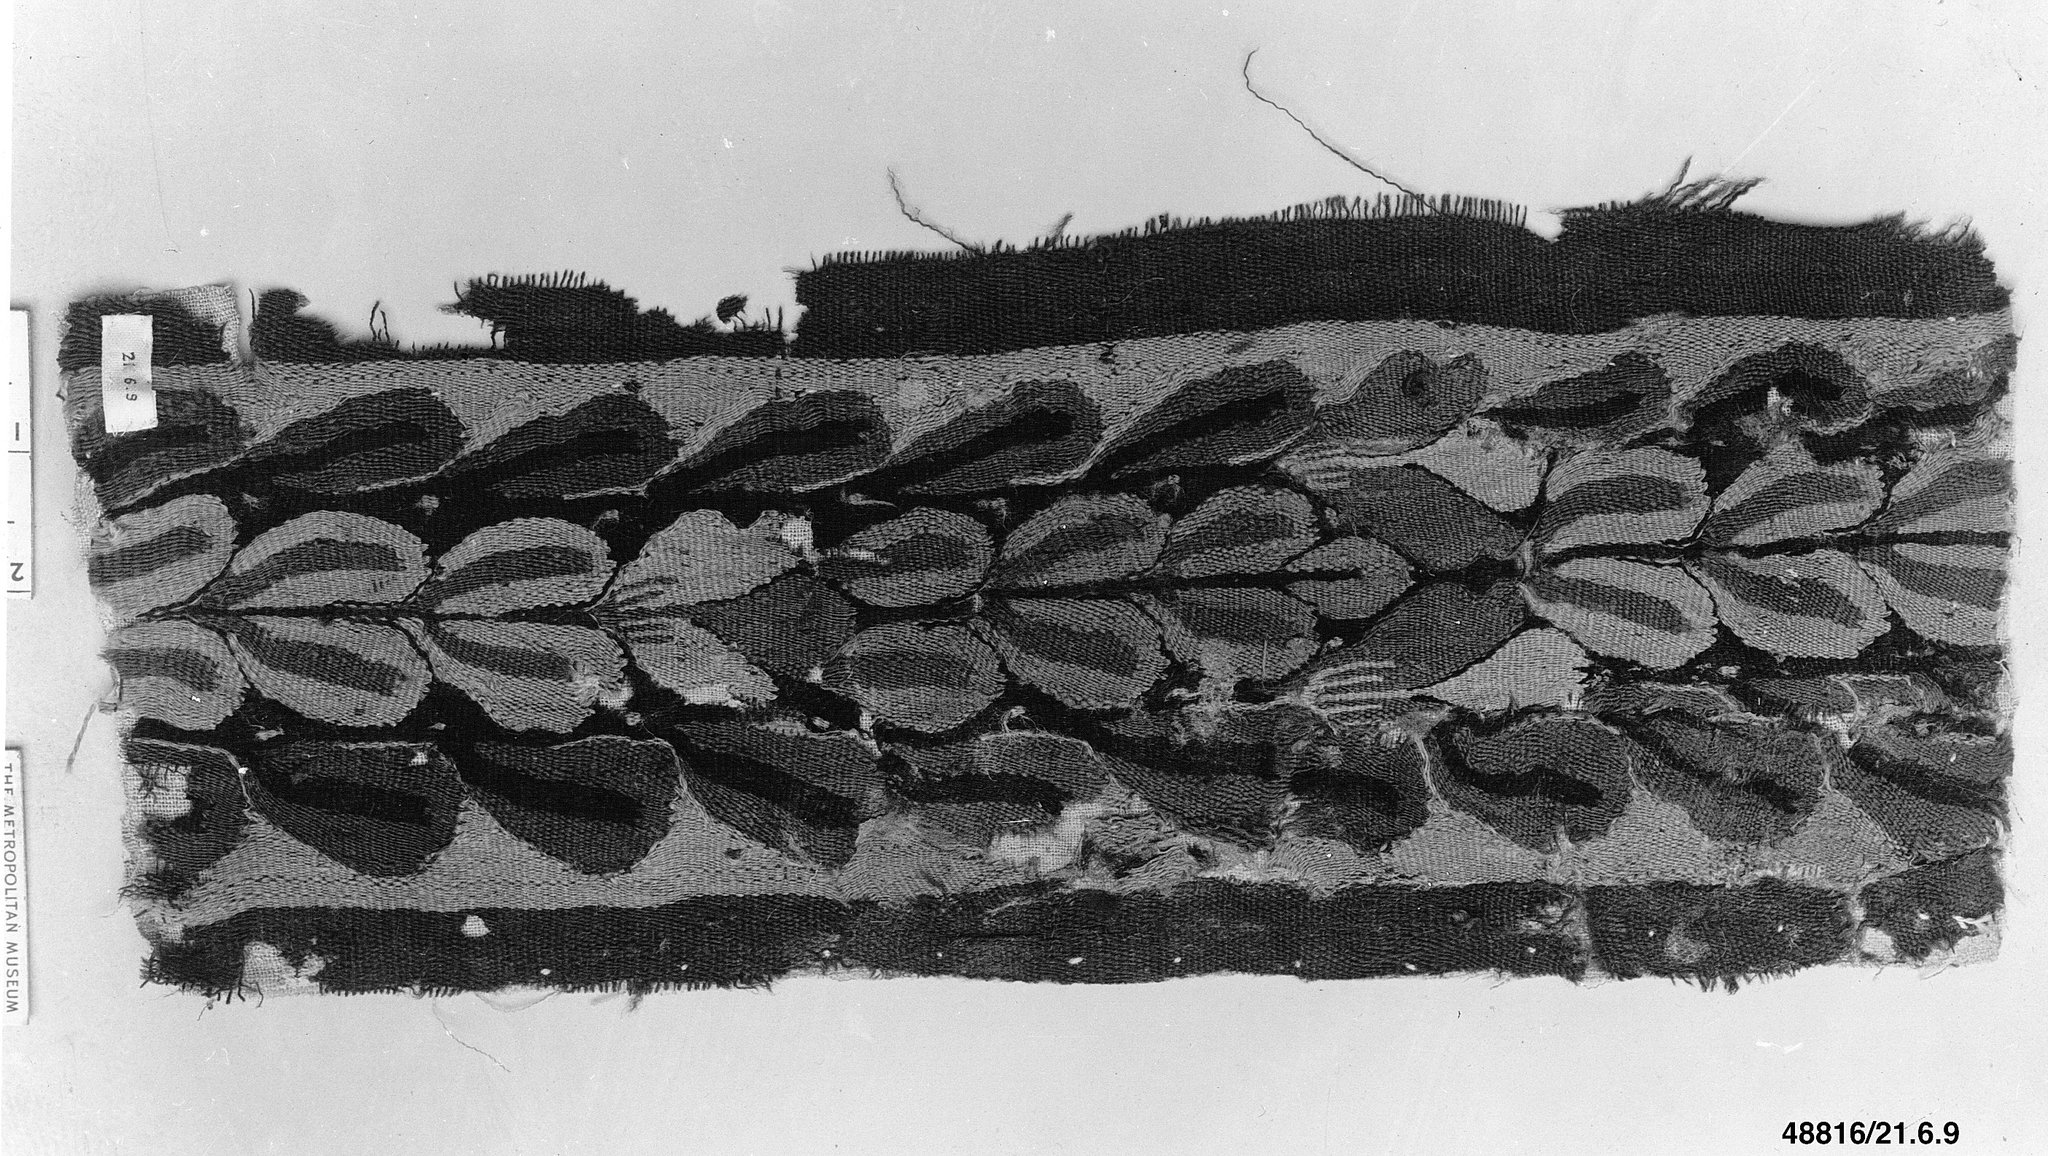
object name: band fragment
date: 401-500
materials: wool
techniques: tapestry, weave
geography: egypt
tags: leaves